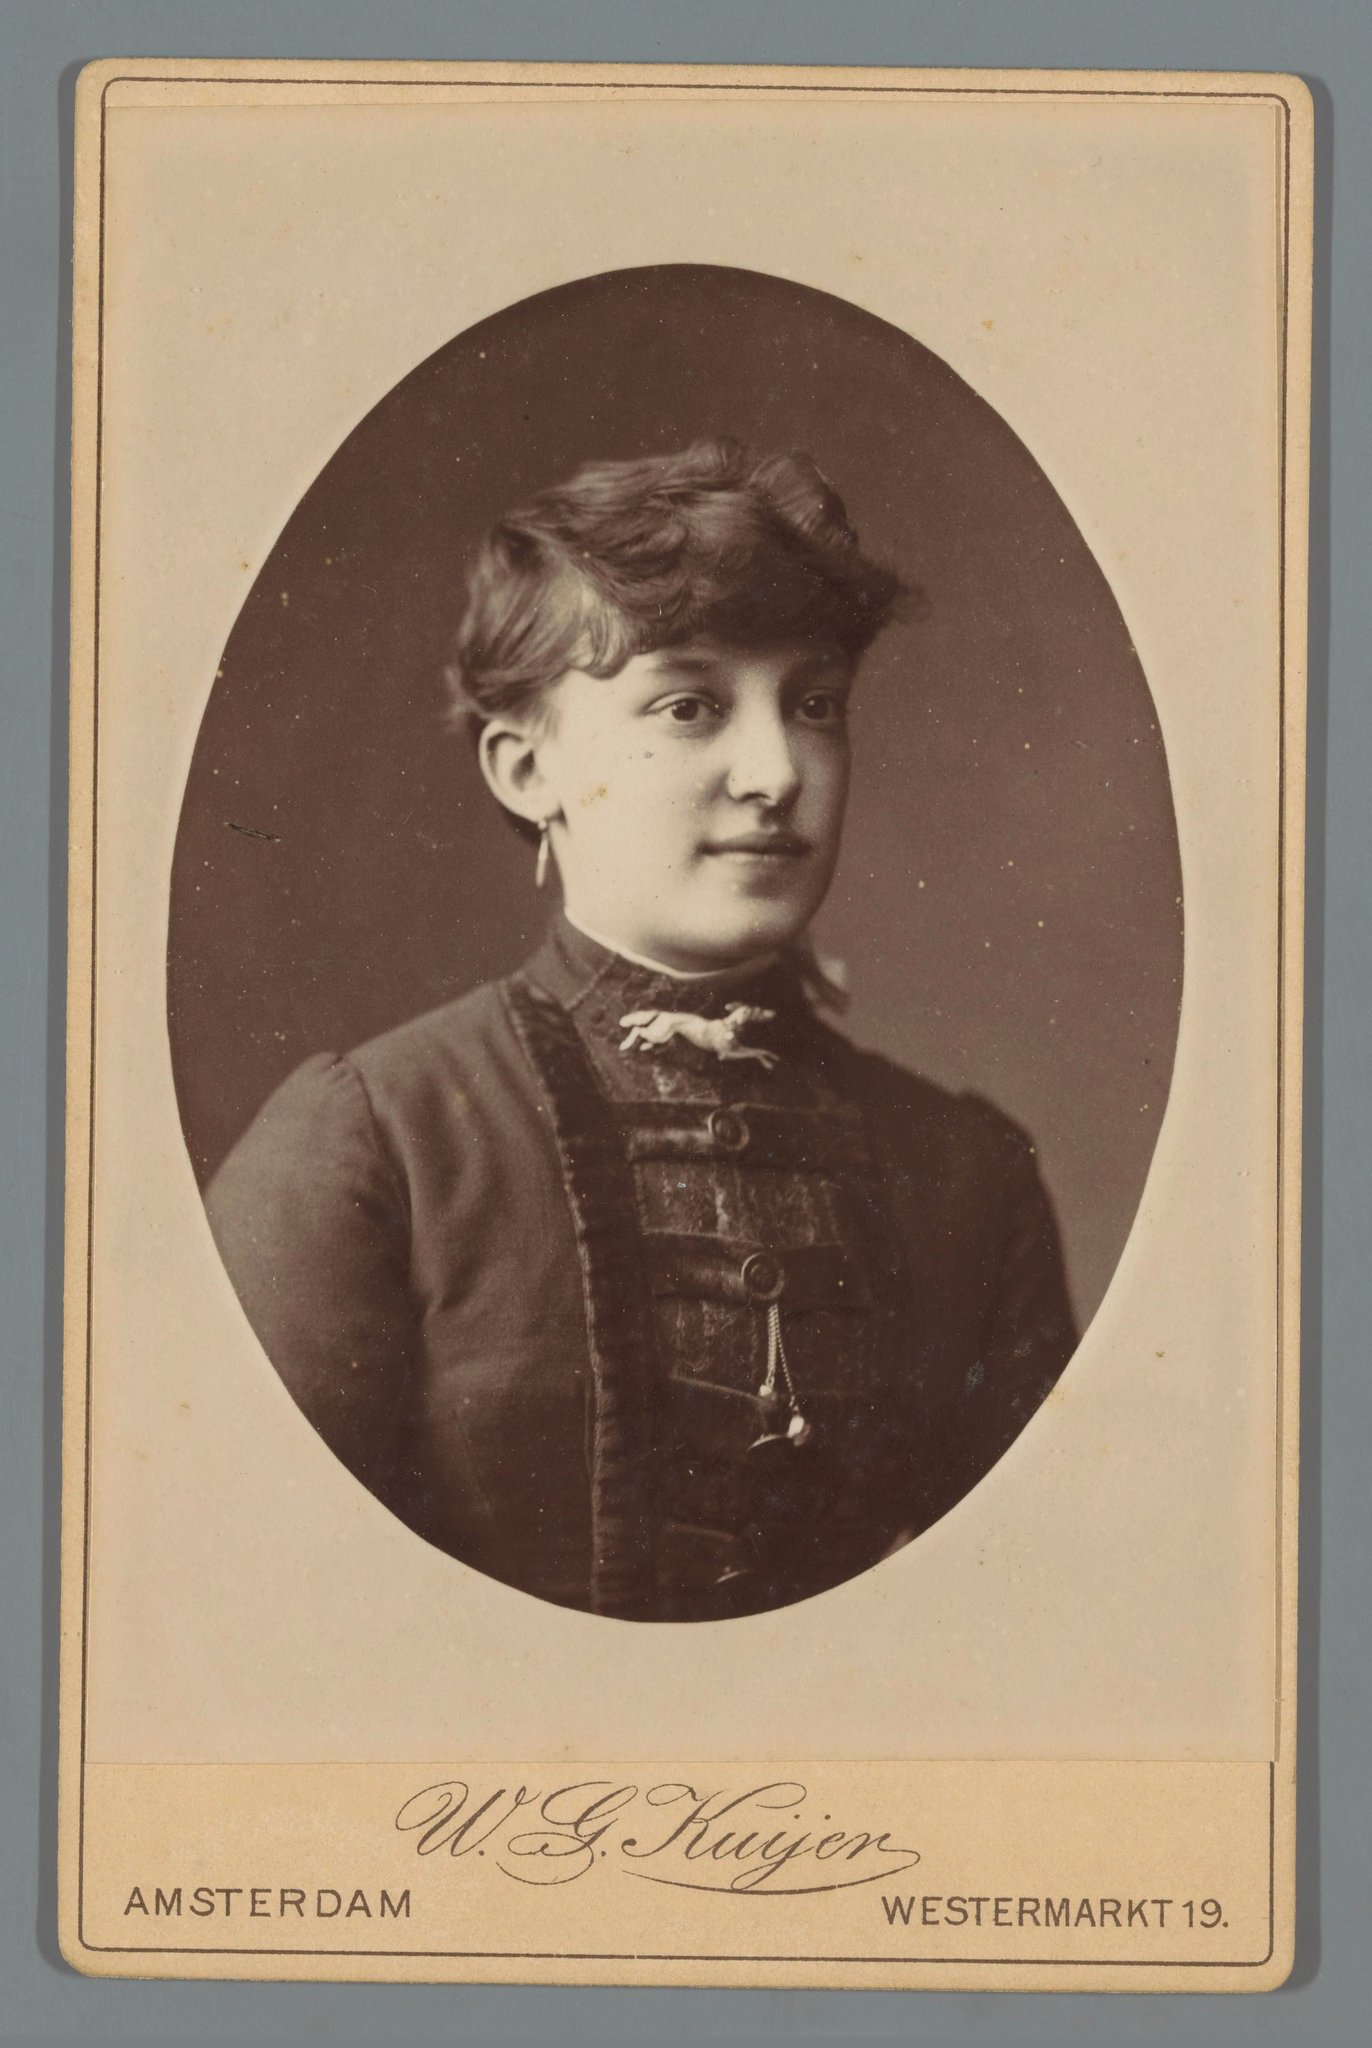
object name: cabinet photograph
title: Portret van een onbekende vrouw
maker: willem gerhardus kuijer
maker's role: fotograaf, hoffotograaf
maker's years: 1834-1899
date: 1862-1899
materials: cardboard, photographic support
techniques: albumen print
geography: amsterdam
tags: adult woman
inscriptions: name: ‘W.G. Kuijer Westermarkt 19. Amsterdam.’